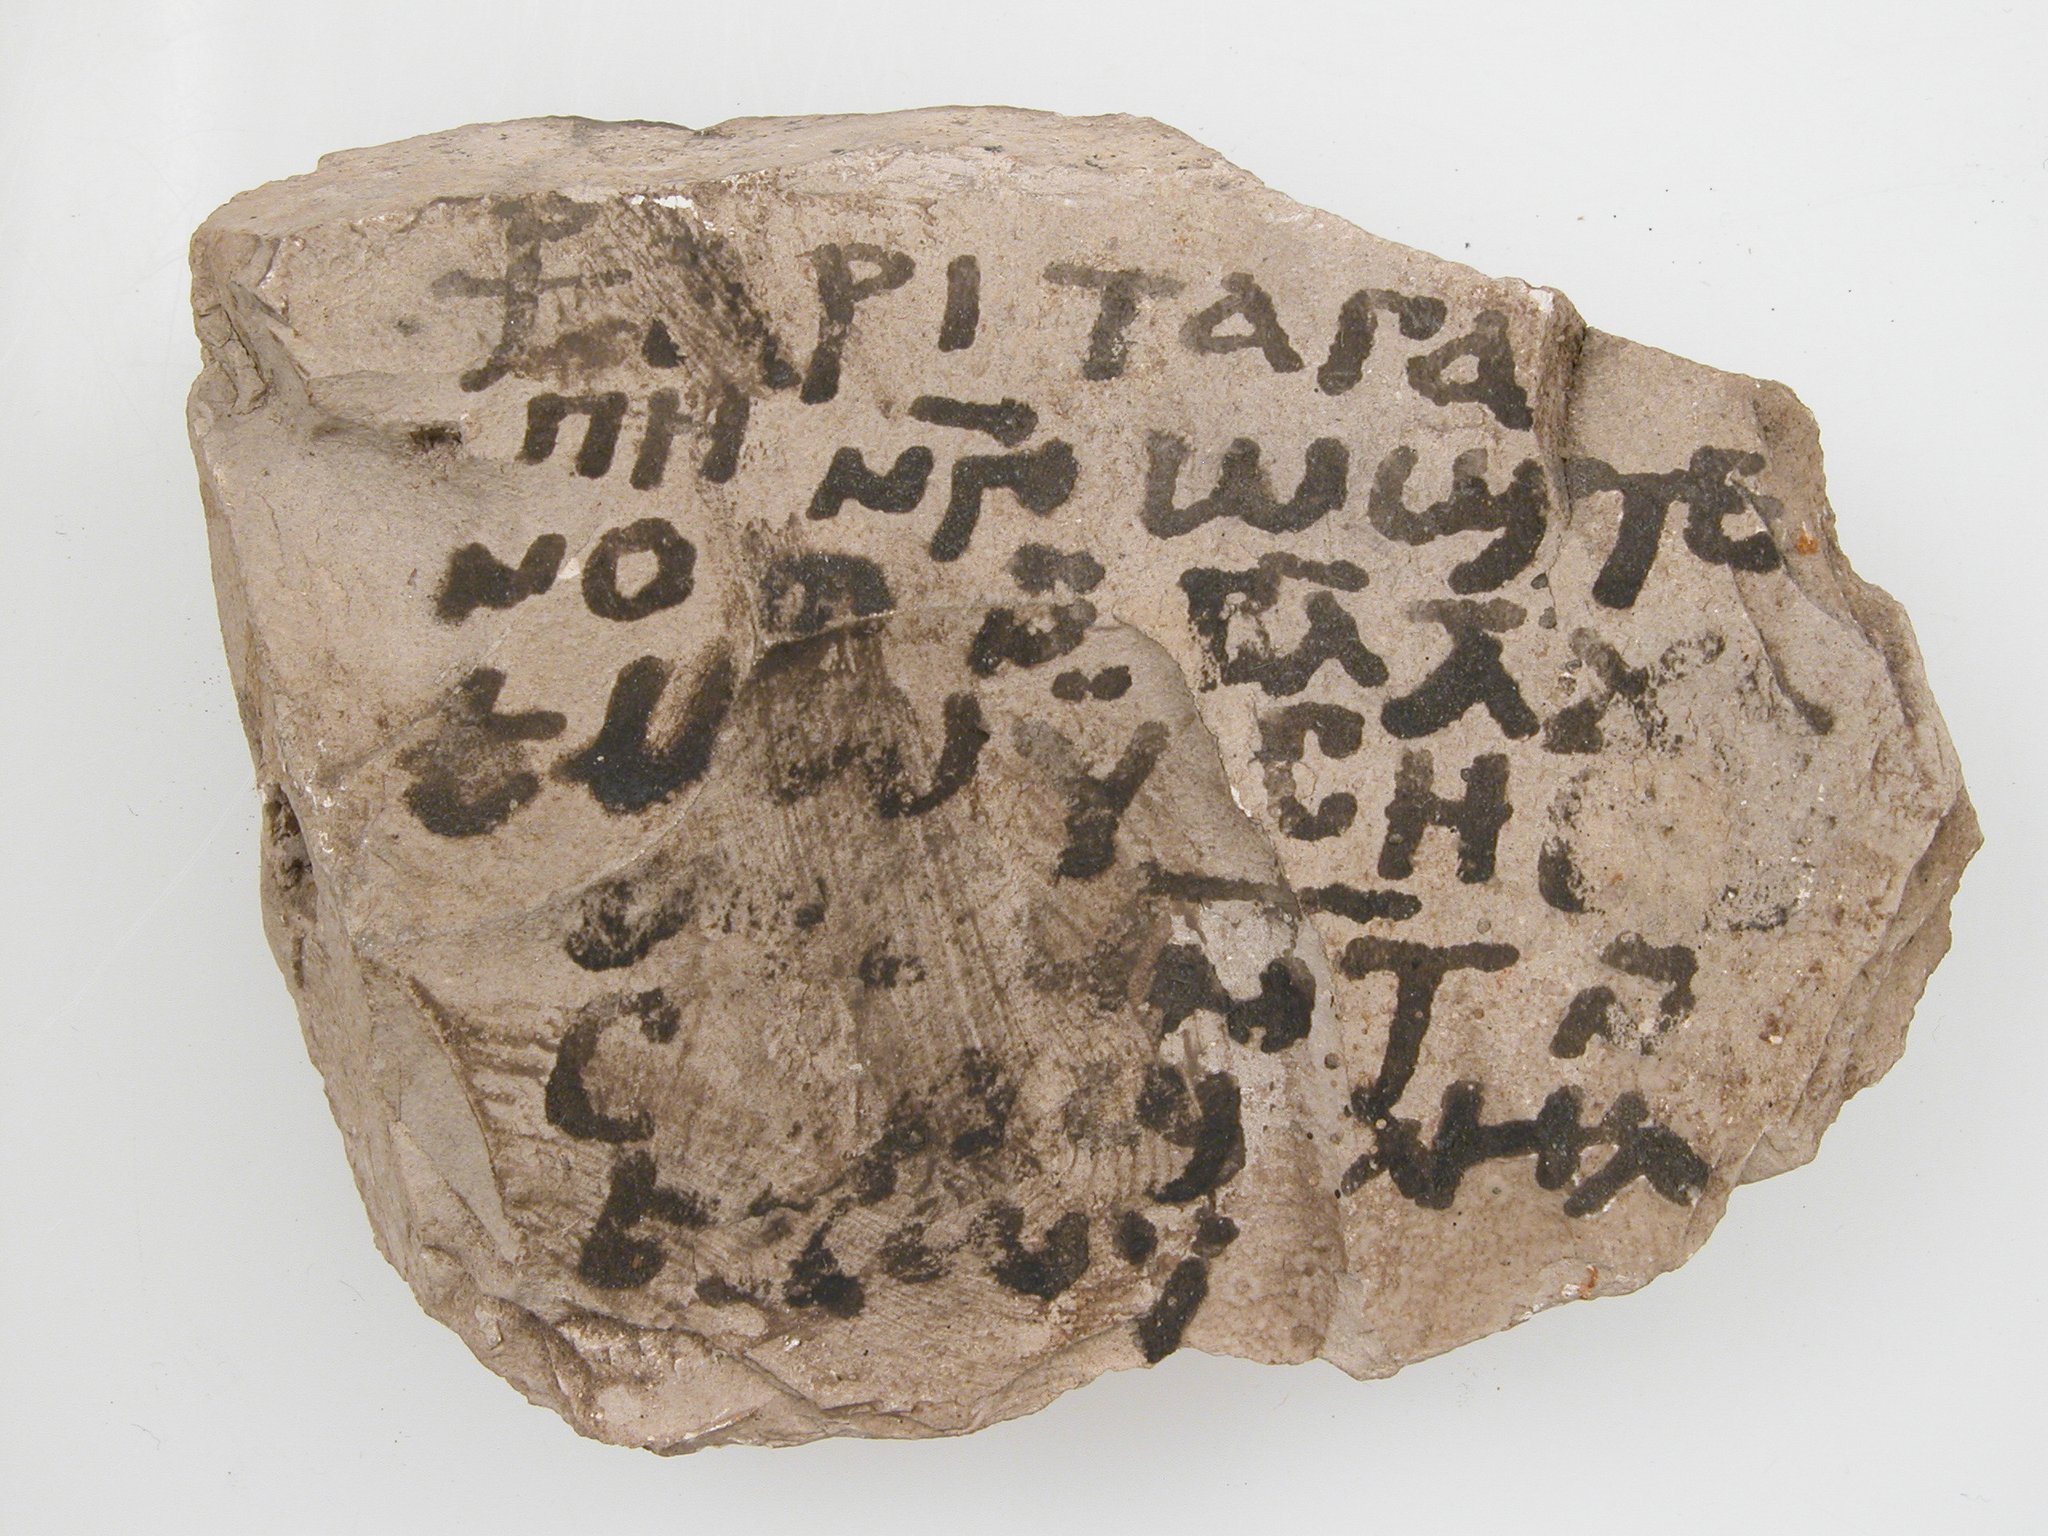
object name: ostrakon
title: Ostrakon with a Letter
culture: coptic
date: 580-640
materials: ink, limestone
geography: egypt